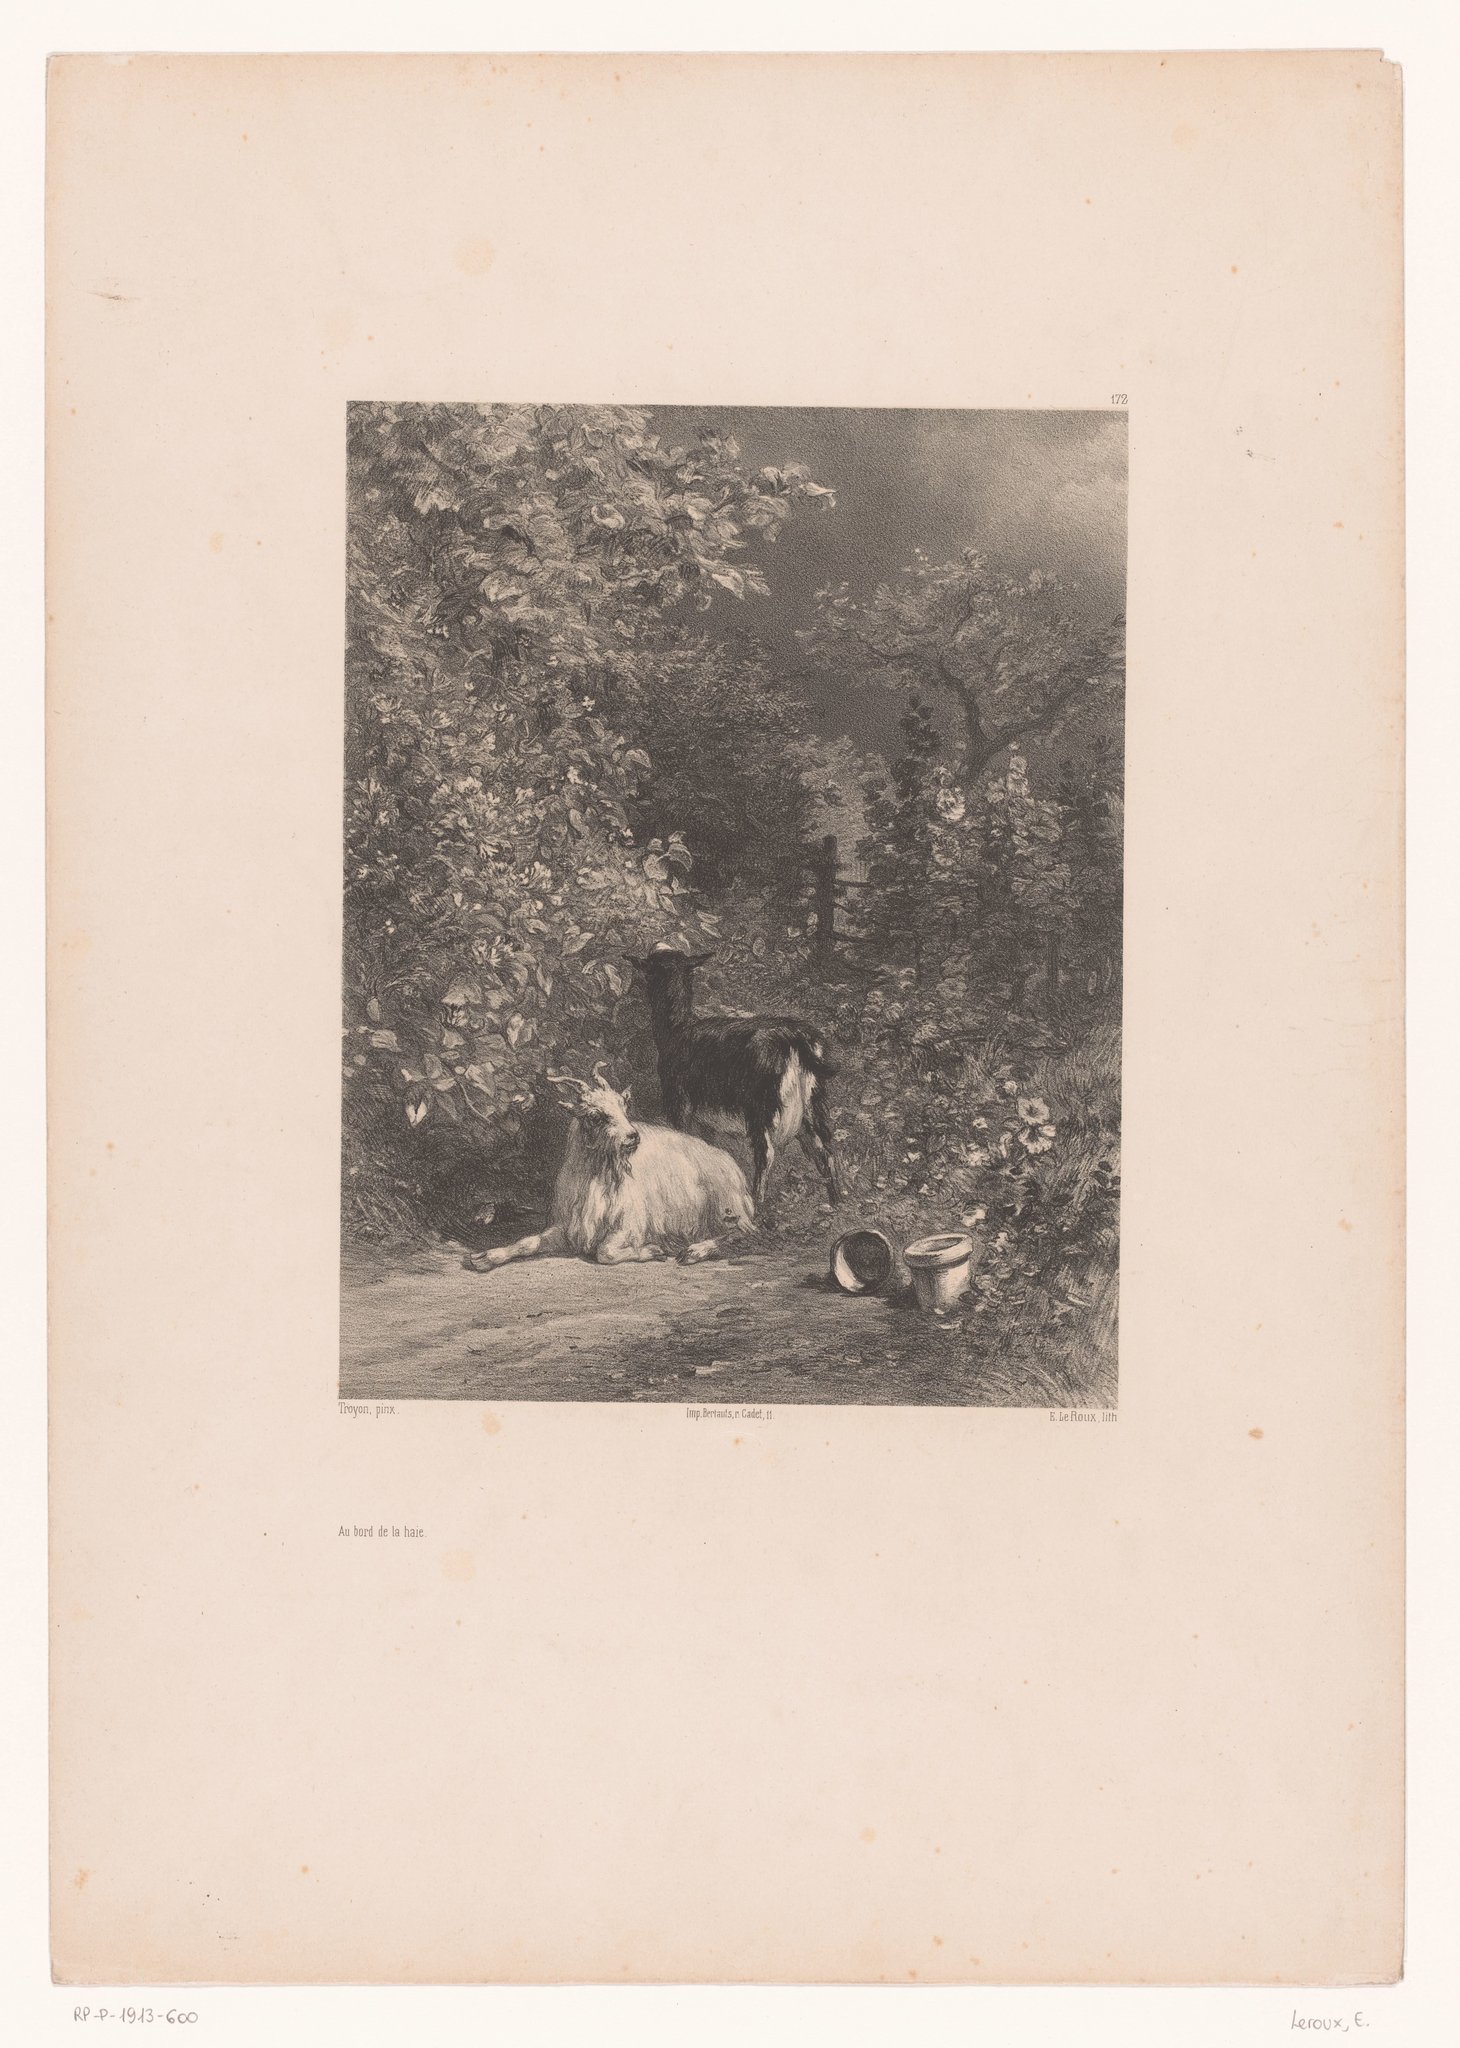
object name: print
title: Au bord de la haie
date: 1858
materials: paper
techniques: lithography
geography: paris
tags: garden, goat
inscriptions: collector's mark: Lugt 2233, check stamp: Lugt 36a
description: Prent gebruikt voor: Les Artistes anciens et modernes, dl. 8, 1858.